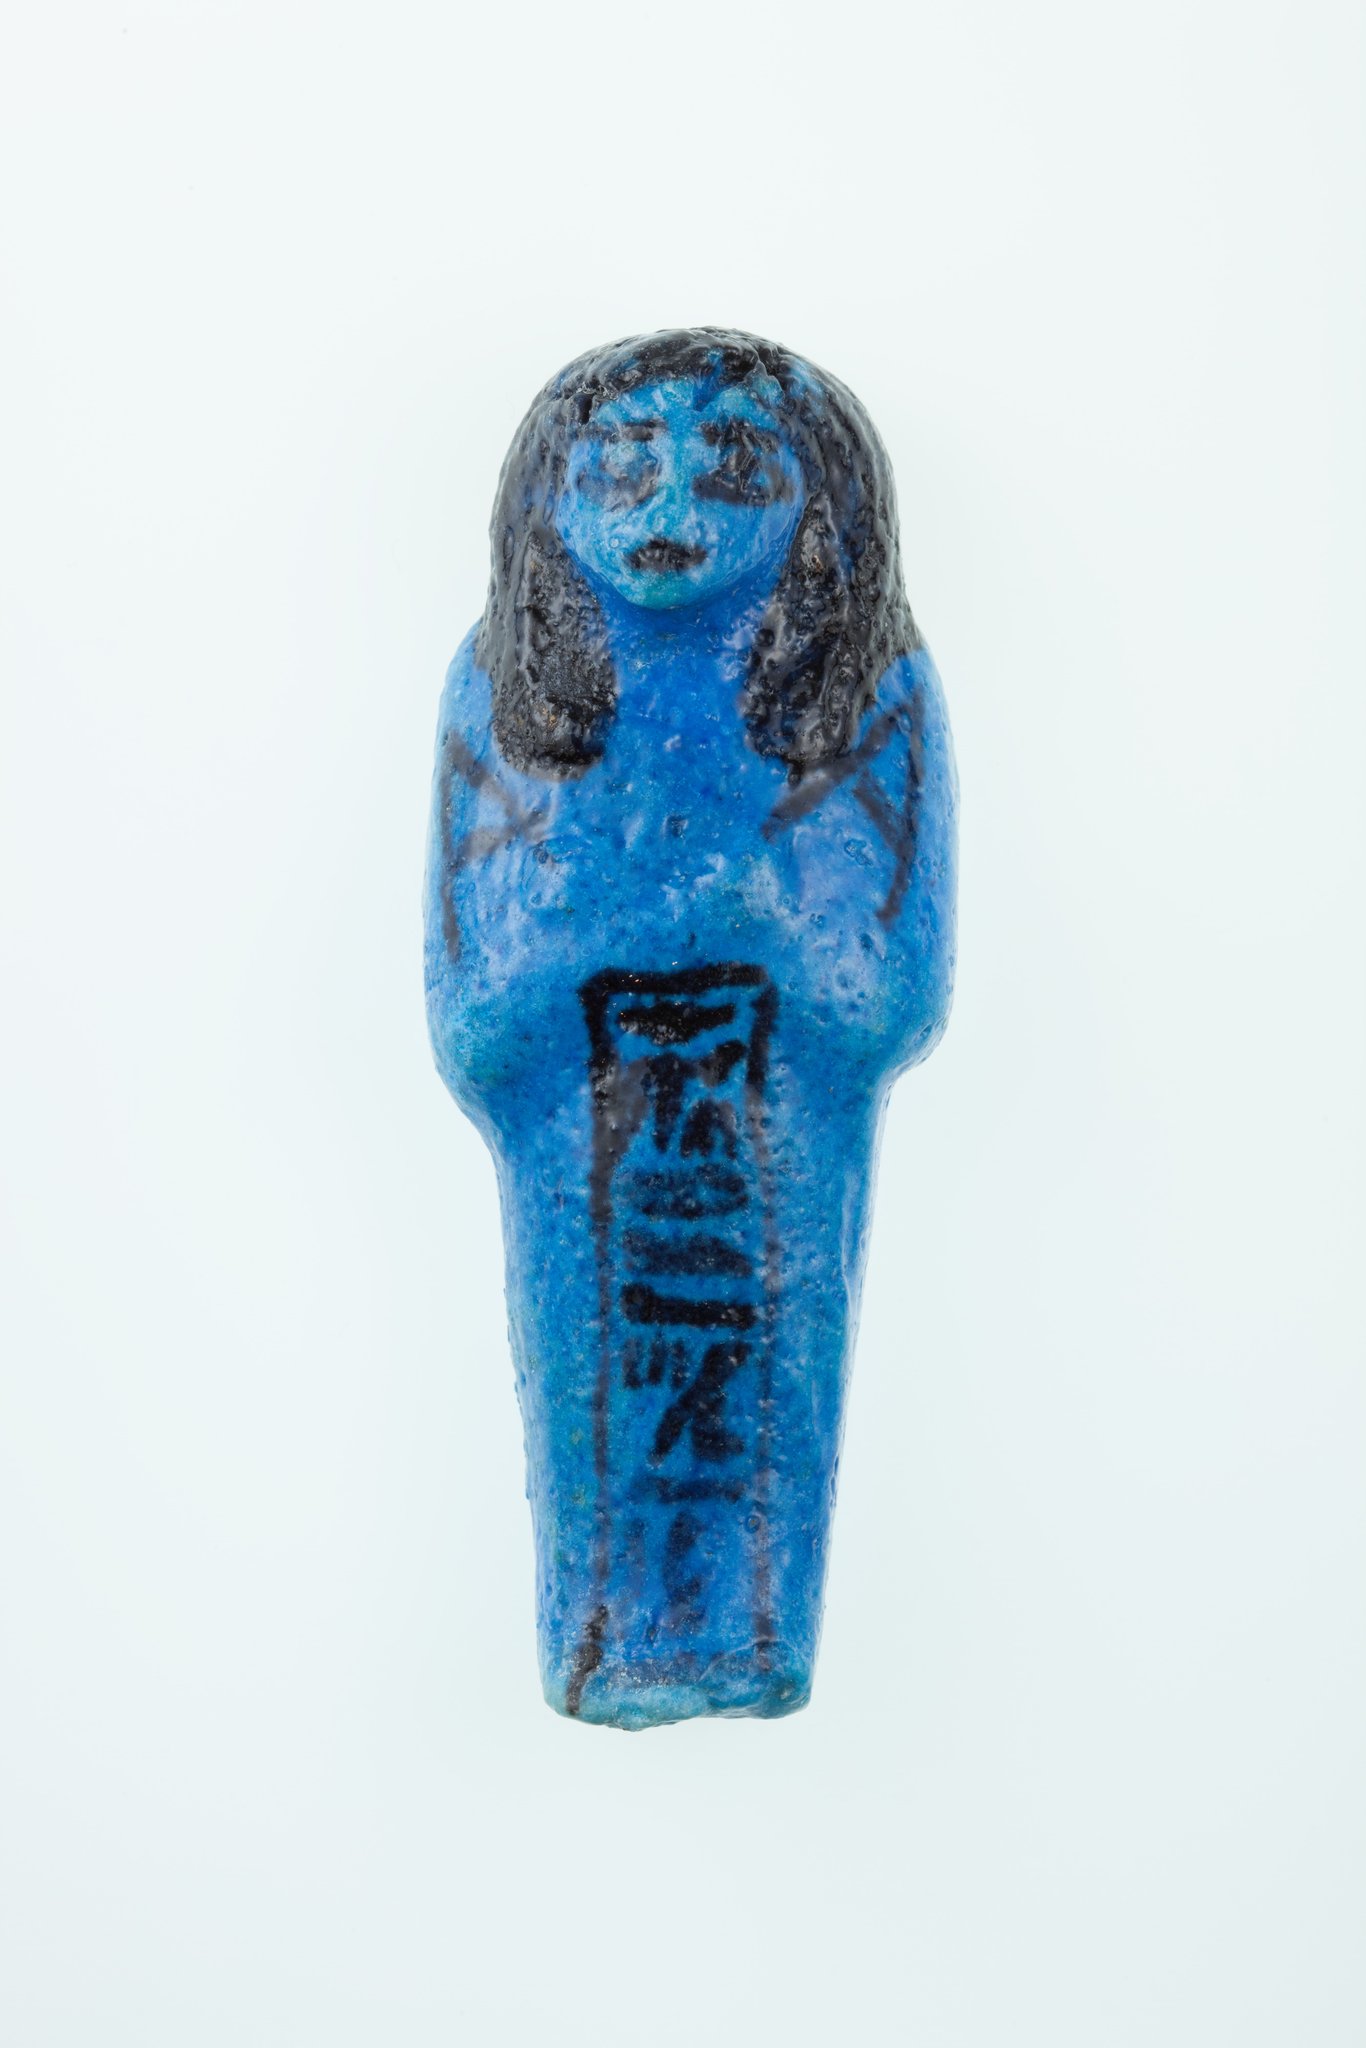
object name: shabti, worker, nauny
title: Worker Shabti of Nauny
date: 1050 BCE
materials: faience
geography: egypt